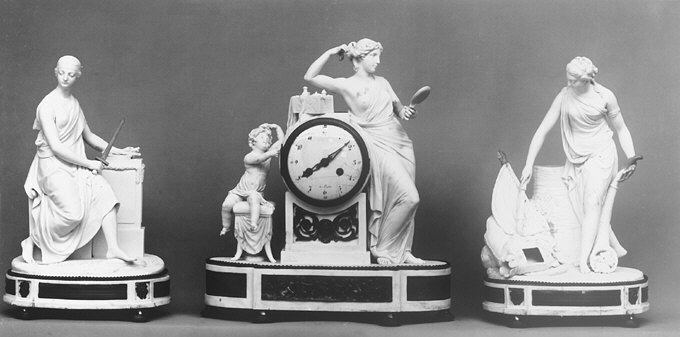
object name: clock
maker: rue de bondy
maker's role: maker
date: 1701-1800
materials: biscuit, gilt bronze, paste, porcelain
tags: children,women